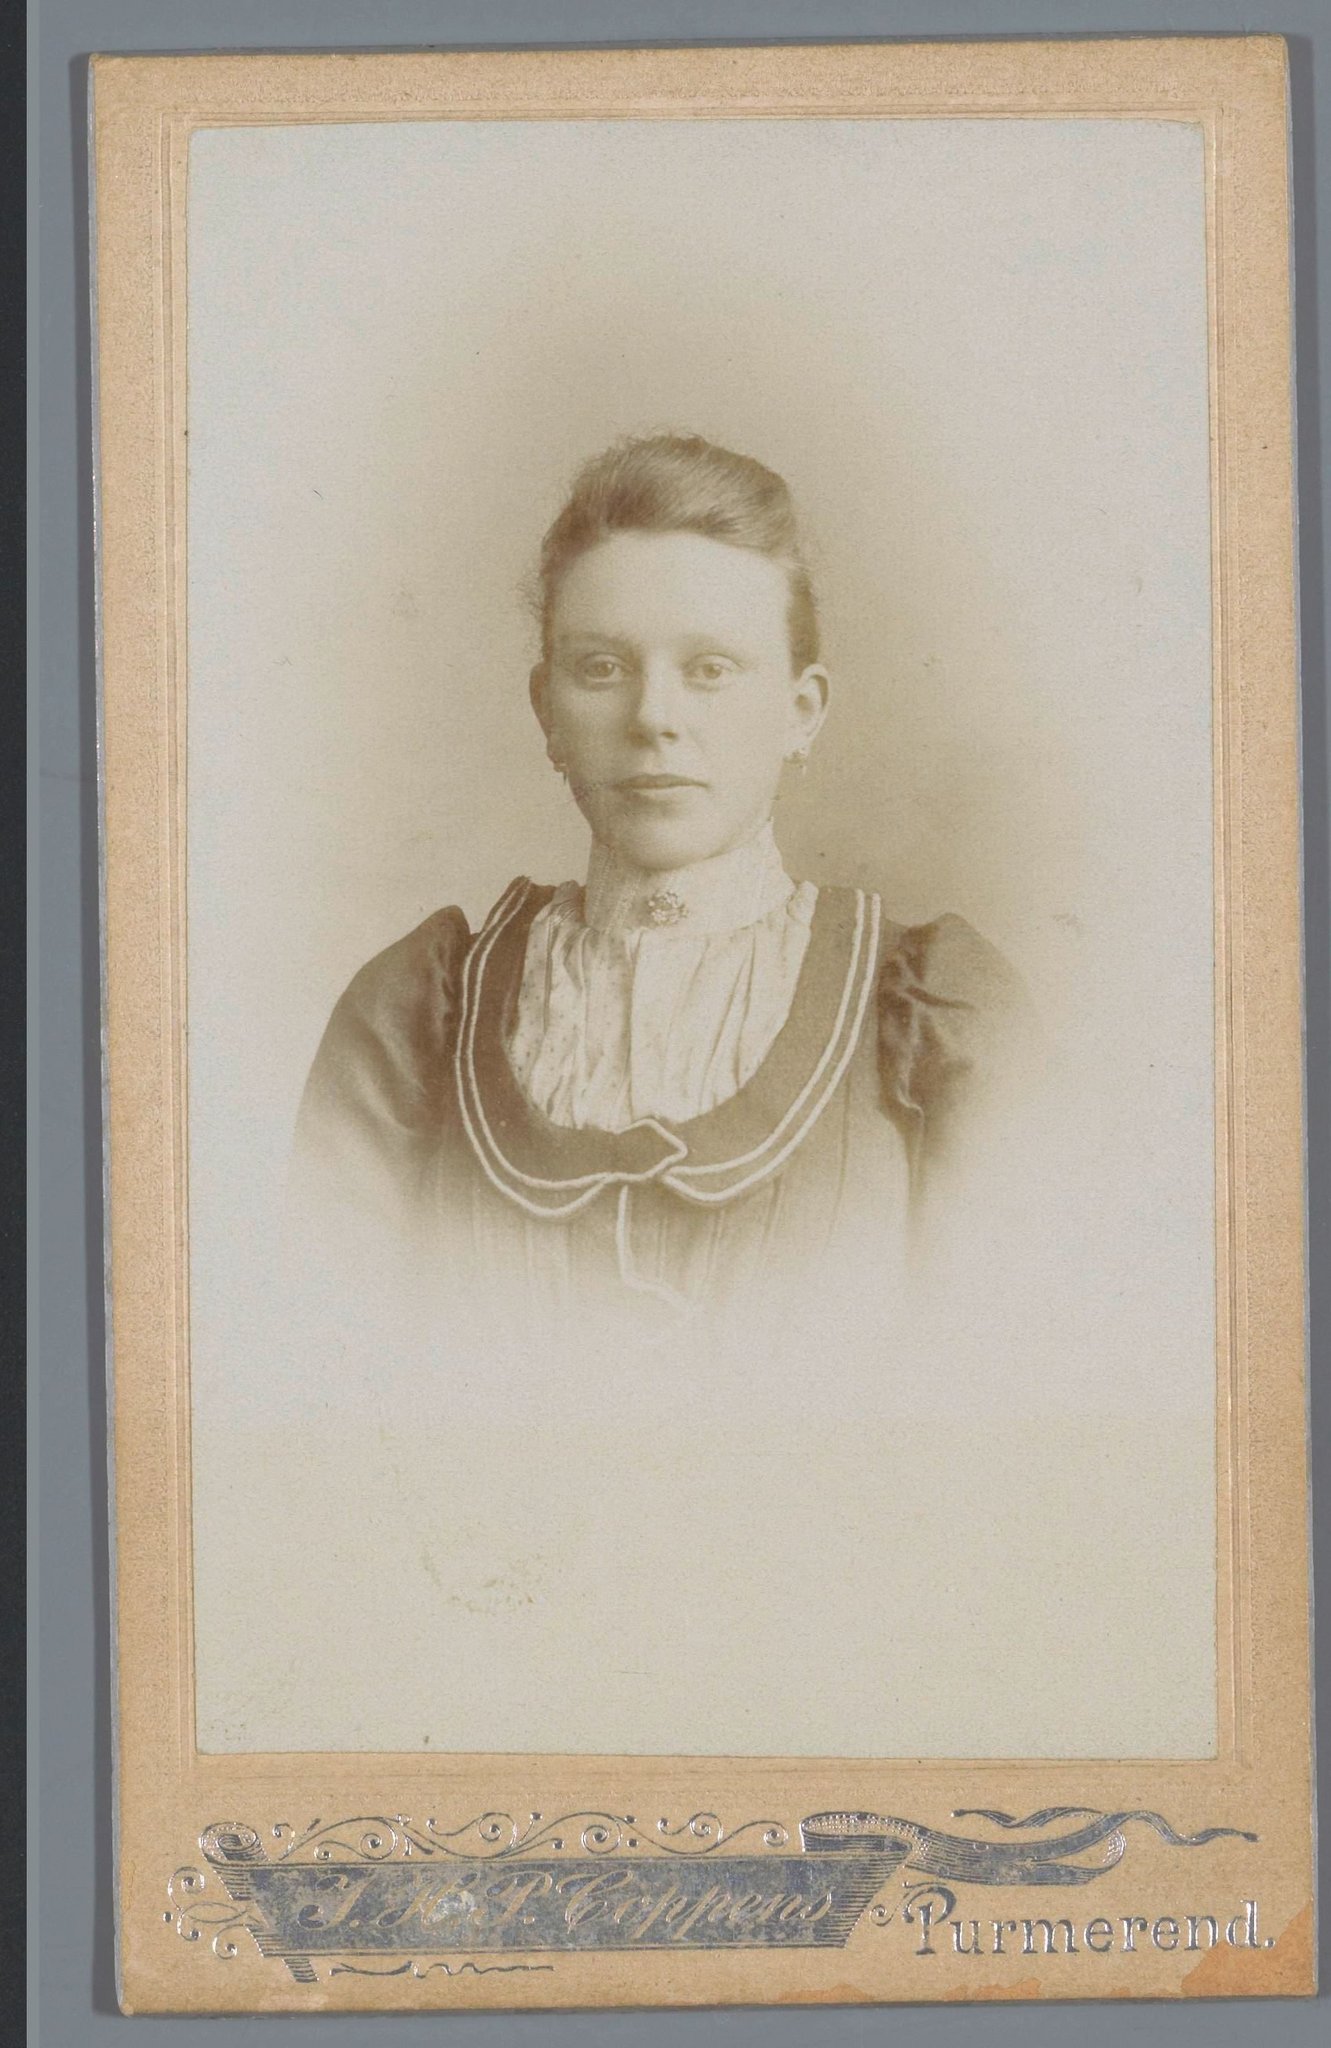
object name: photograph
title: Portret van Aaltje Koster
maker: josephus hendrikus petrus coppens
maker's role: fotograaf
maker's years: 1864-1941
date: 1889-1925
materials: cardboard, photographic support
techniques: gelatin silver print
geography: purmerend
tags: historical persons - bb - woman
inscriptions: inscription: ‘Aaltje Koster’, inscription: ‘Levensgroote olieverfs/ Pastell en Craijon/ Portrettten naar/ Photographie/ J. H. P. Coppens/ Photograaf/ en/ Portretschilder/ Purmerend./ Negatieven voor nabestelling bewaard.’